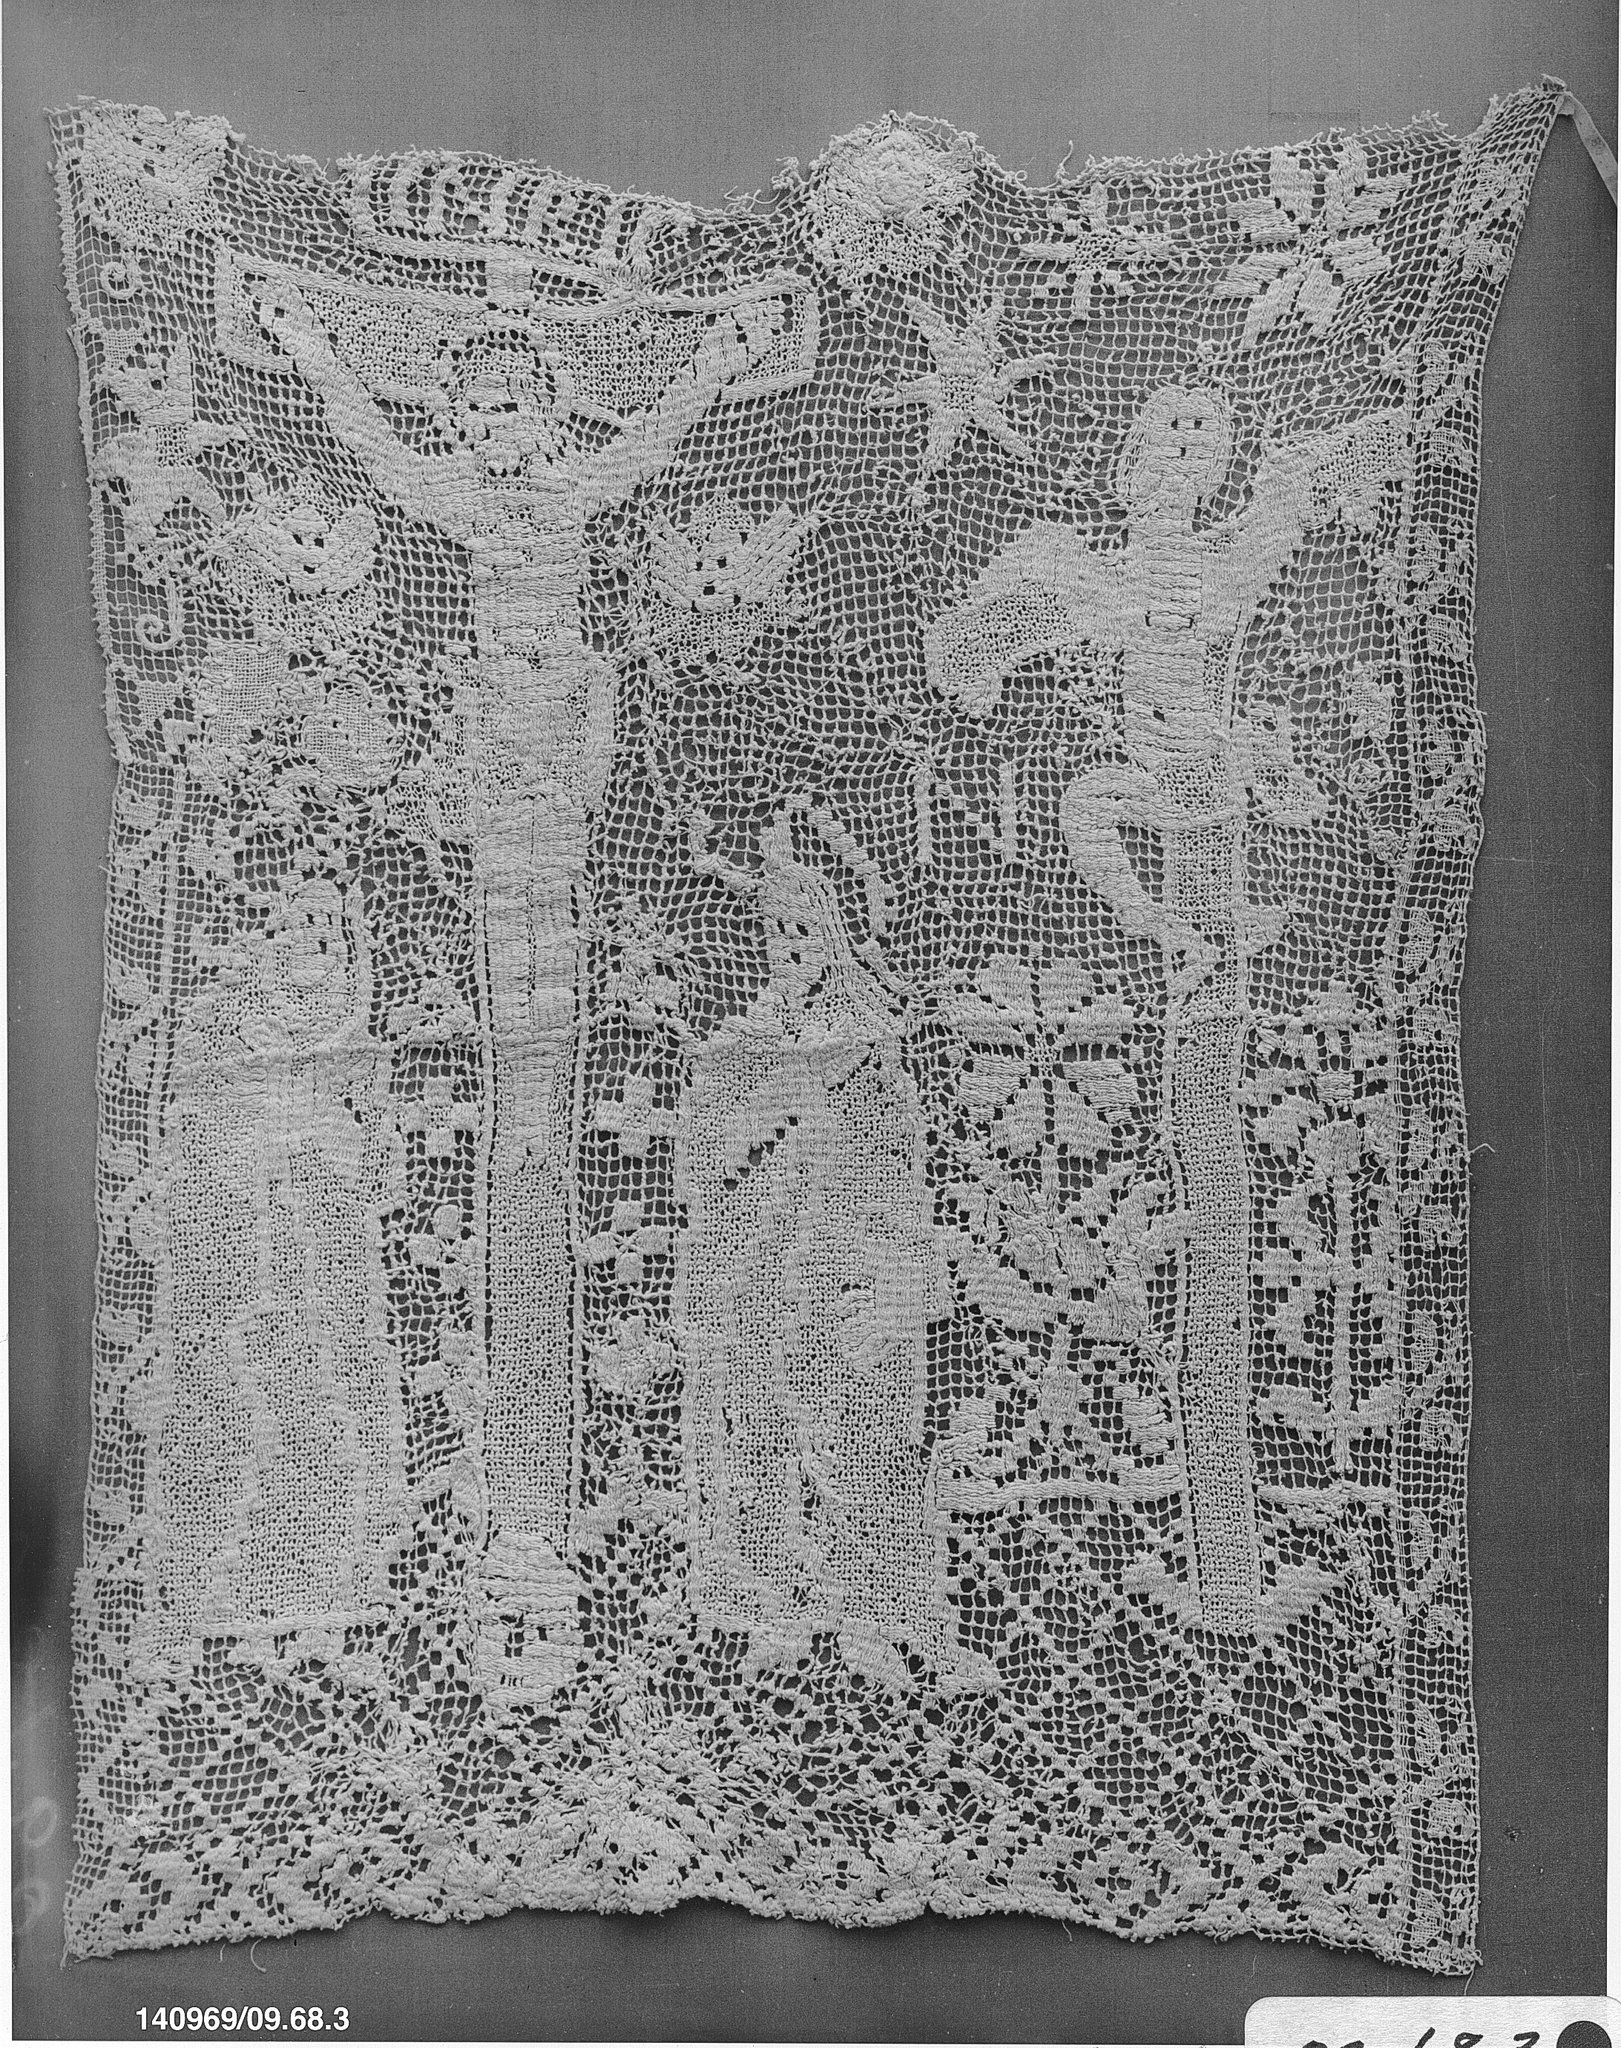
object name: panel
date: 1501-1600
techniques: lace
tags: cross,jesus,crucifixion